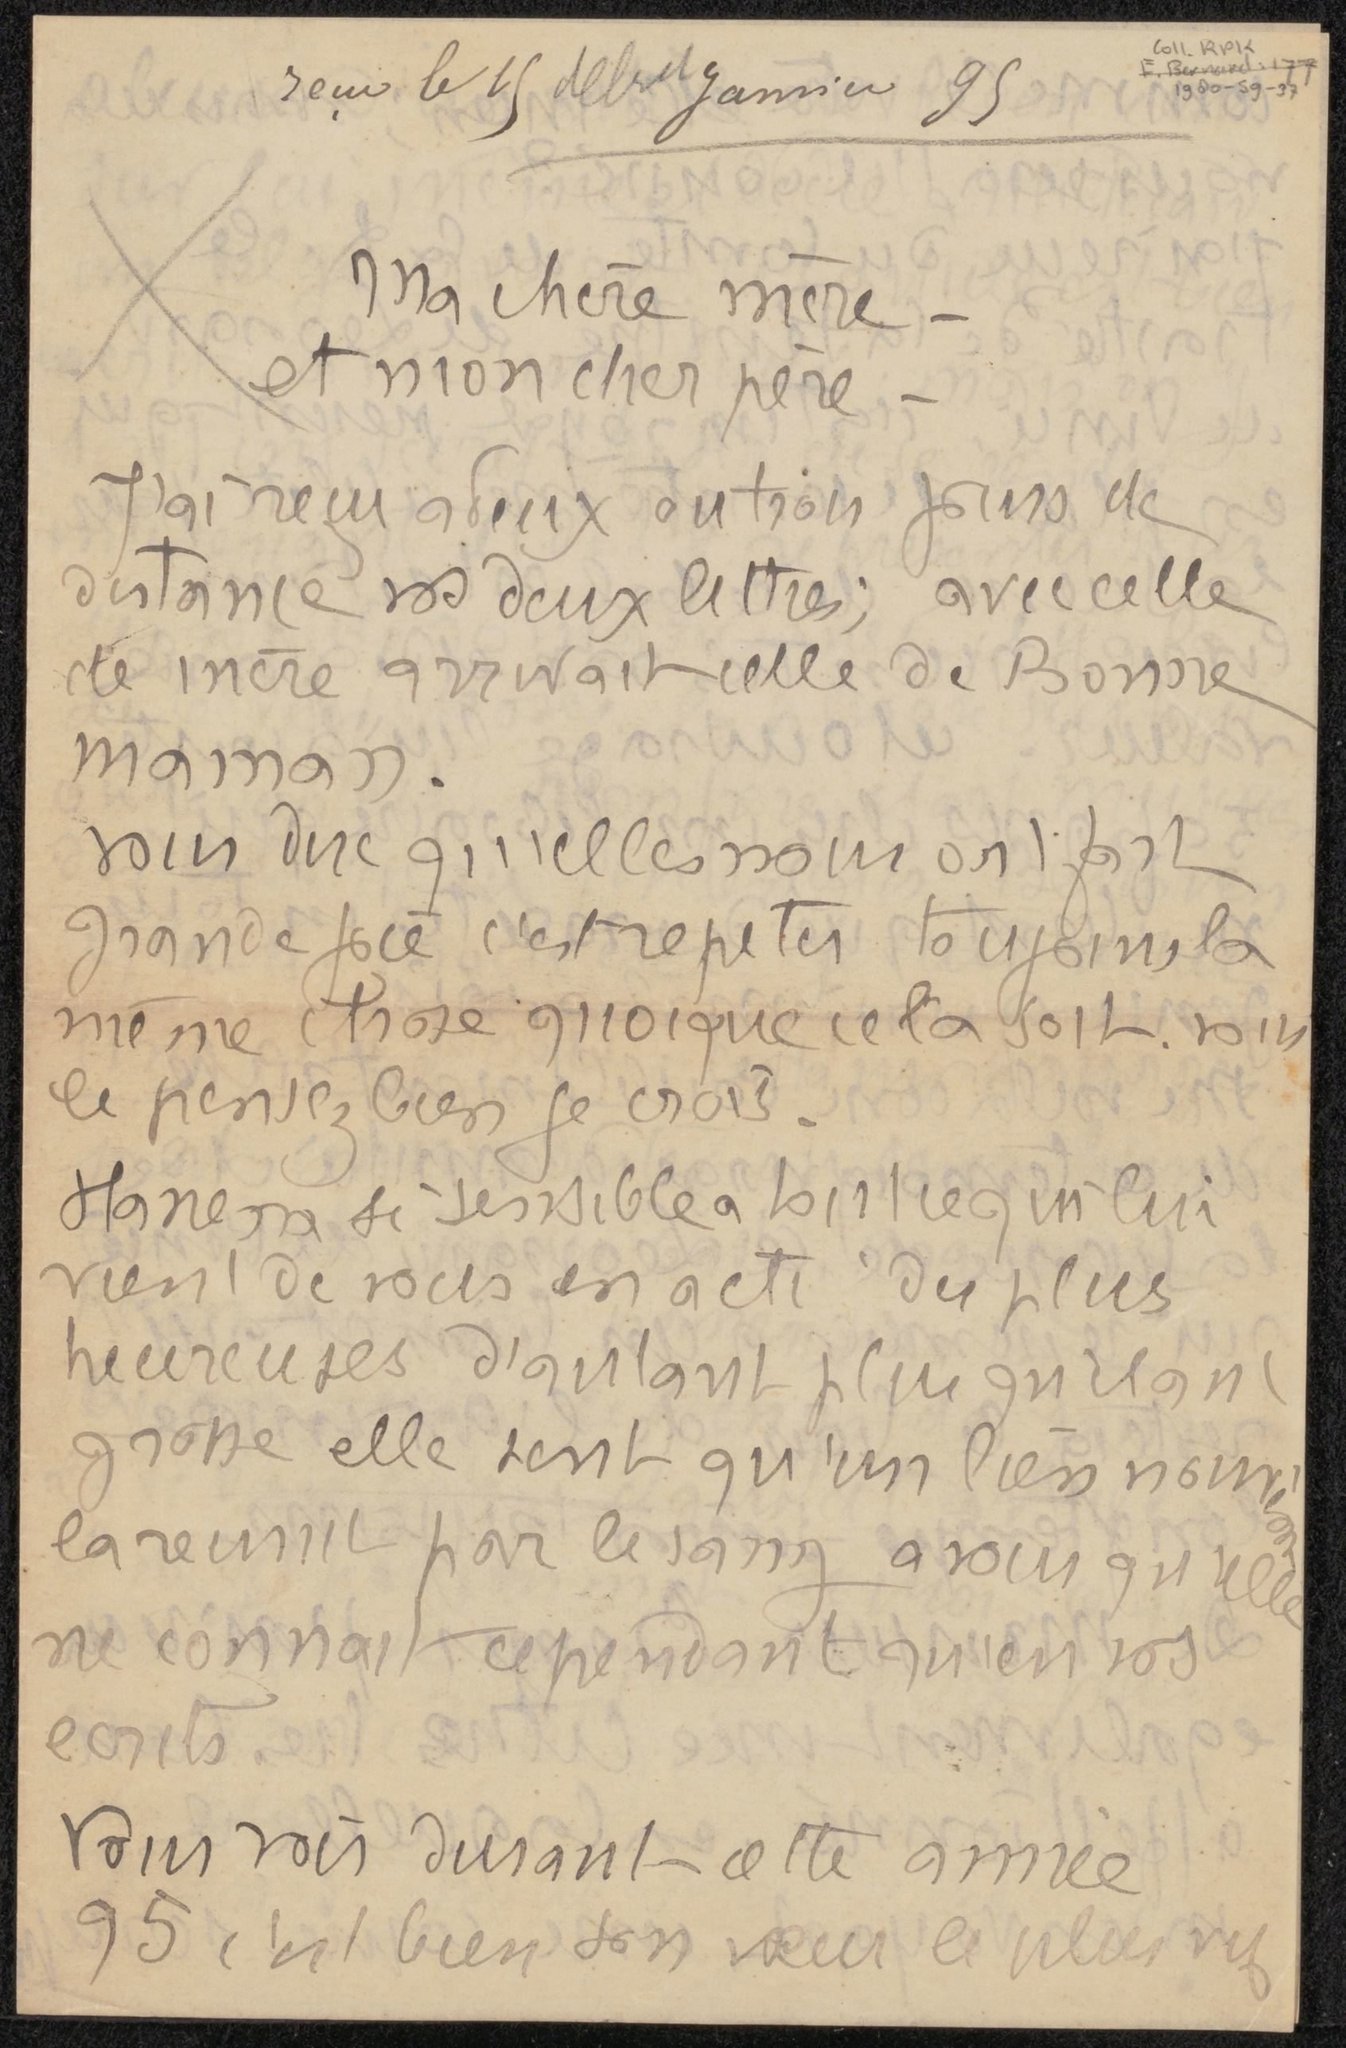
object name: letter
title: Brief aan Emile Ernest Bernard en Héloïse Bernard-Bodin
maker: émile bernard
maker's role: print maker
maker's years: 1868-1941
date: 1895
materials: ink, paper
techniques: pen, writing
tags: héloïse bernard-bodin, emile ernest bernard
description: Brief gedateerd 11 Janvier 1895 in latere hand.